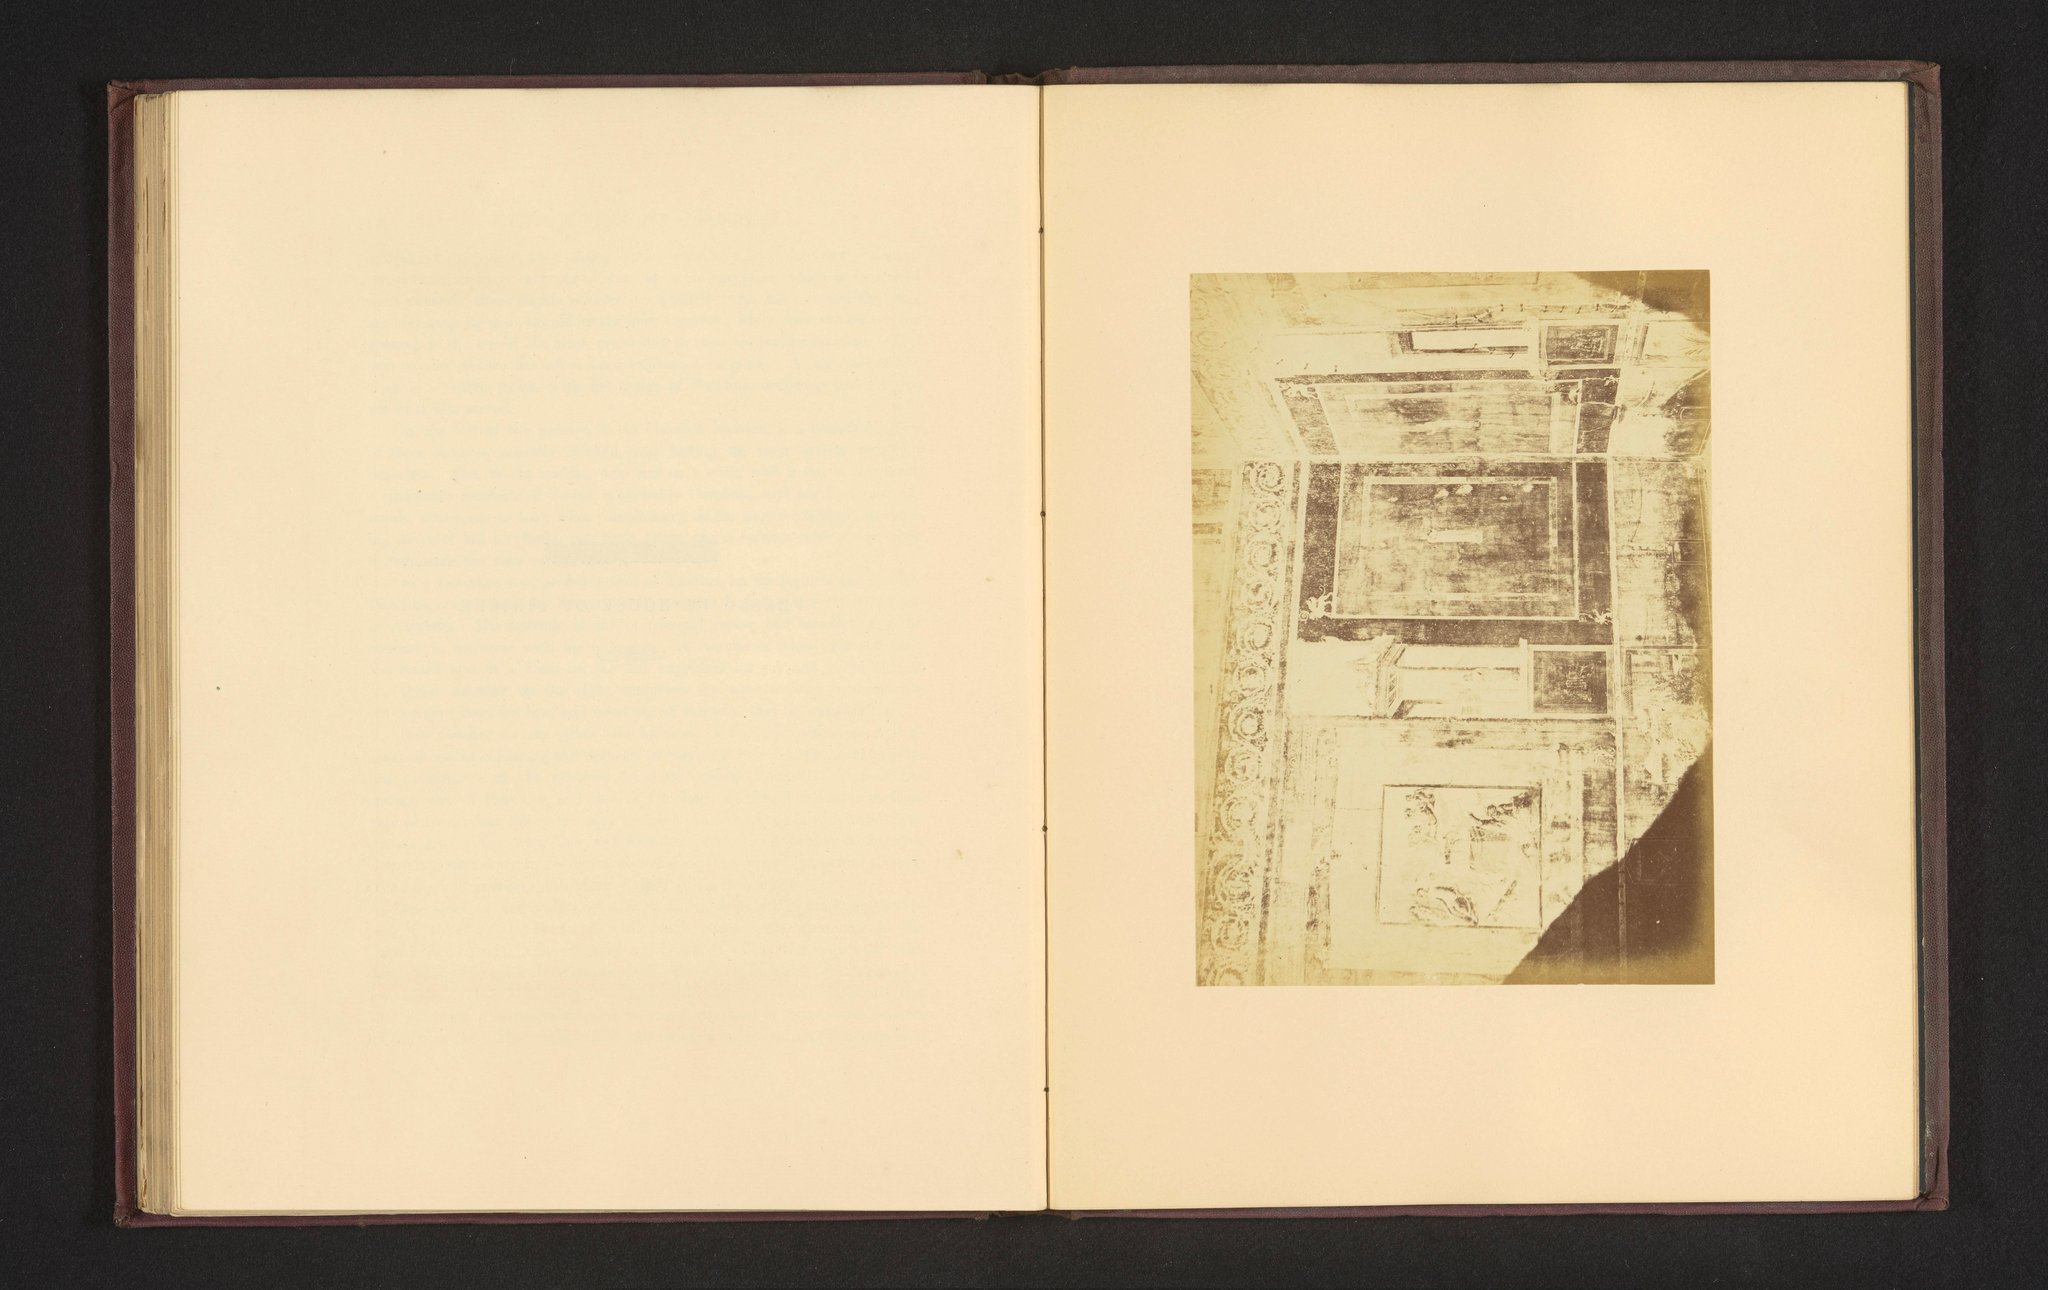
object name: photograph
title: Gezicht op een fresco in het Huis van Siricus te Pompeï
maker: Anonymous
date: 1862-1867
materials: cardboard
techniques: albumen print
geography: pompeii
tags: painting, drawing and the graphic arts, pompeii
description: Foto op derde ongenummerde pagina na pagina 82.